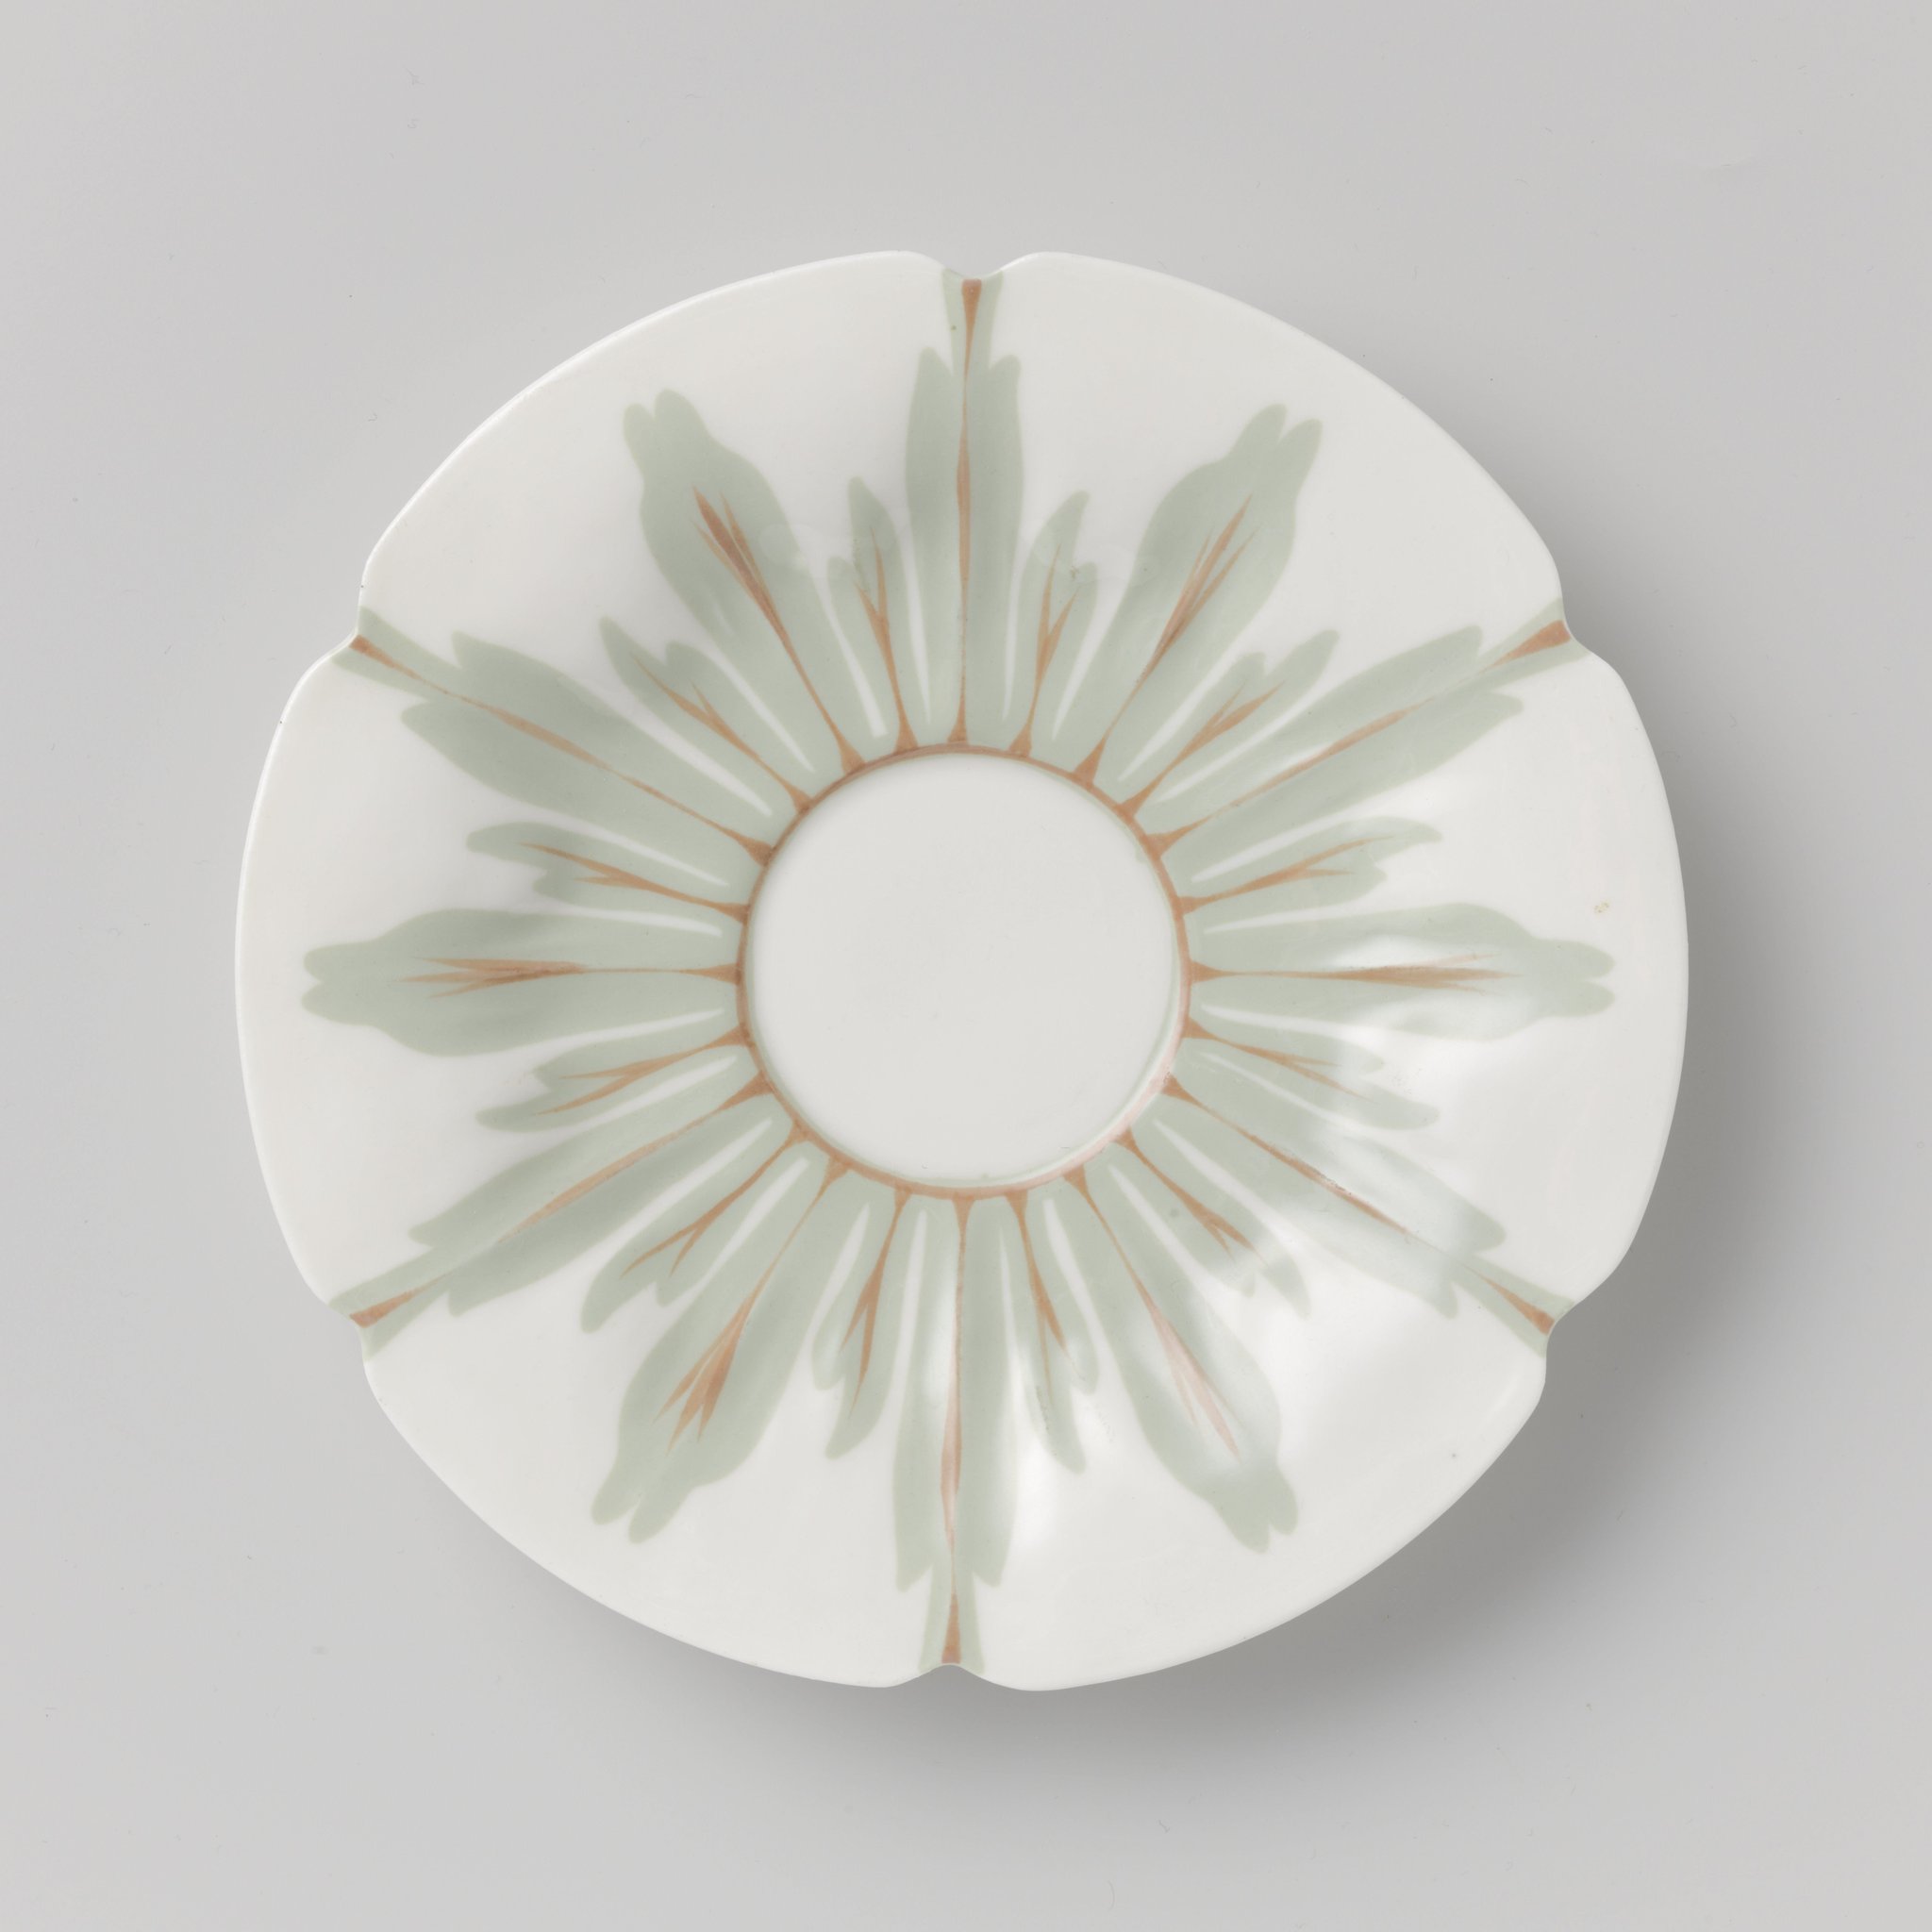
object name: platter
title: Schotel, beschilderd met het Krokus-decor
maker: konrad hentschel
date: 1896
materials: porcelain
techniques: painted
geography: meissen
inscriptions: model number: ‘Q111’, factory mark, mark: ‘69’, mark: ‘71’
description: Schotel van beschilderd porselein. De schotel is beschilderd in groen en bruin. De schotel is gemerkt.